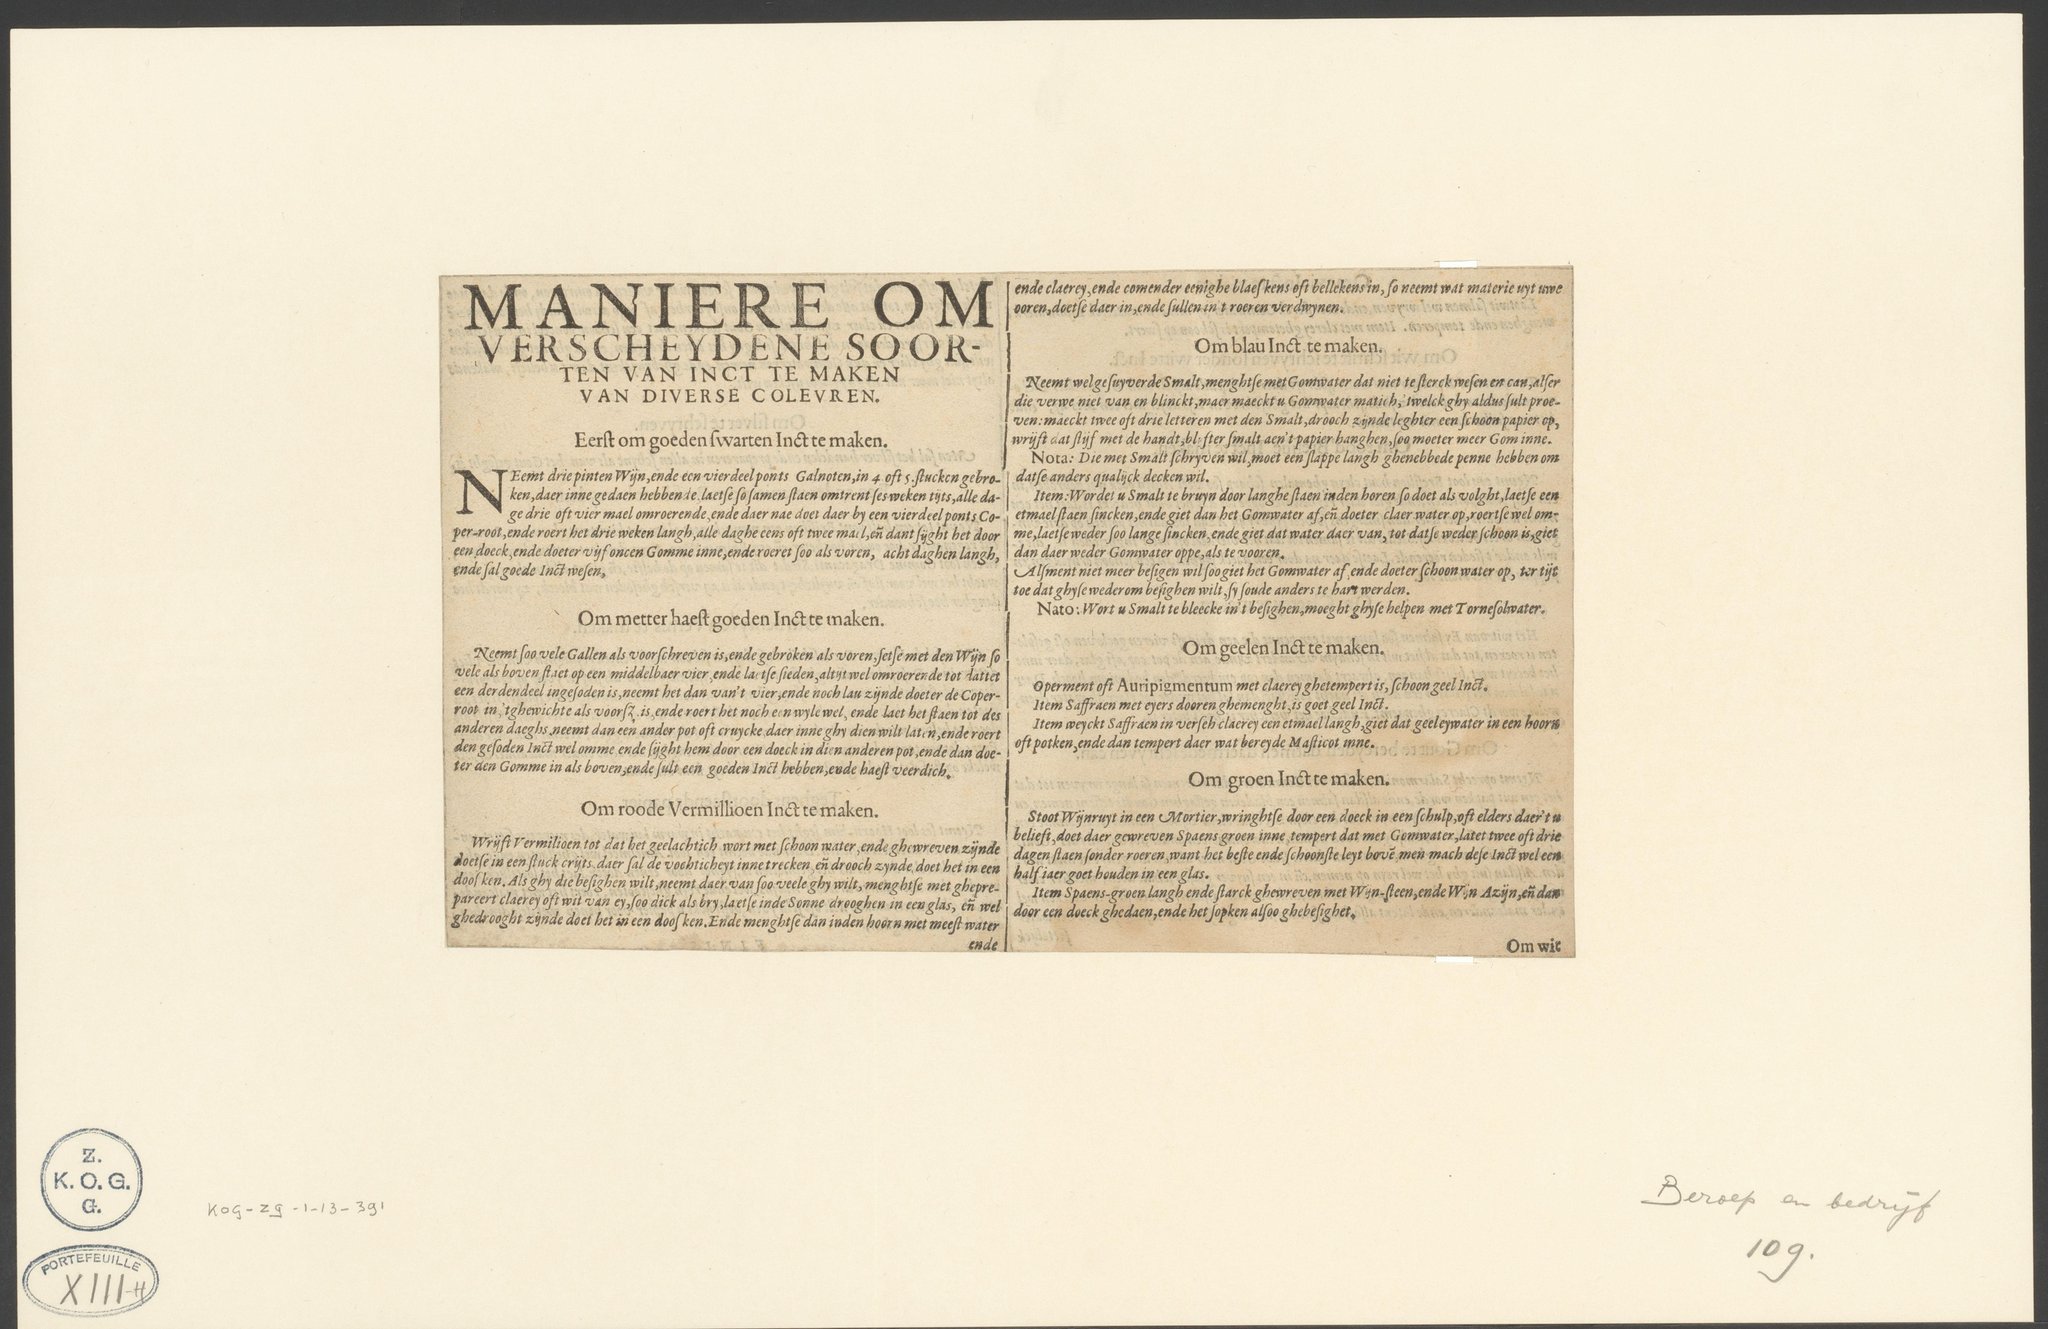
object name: text sheet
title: Instructie om verschillende soorten en kleuren inkt te maken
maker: Anonymous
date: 1660-1799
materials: paper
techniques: letterpress printing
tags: painter preparing colours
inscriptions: stamp, collector's mark: Lugt 1641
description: Onderwerpsrubrieken binnen de Atlas Zeden en Gewoonten: Handel, Nijverheid en verkeer, Beroep en bedrijf, Mannelijk, Graphische vakken.